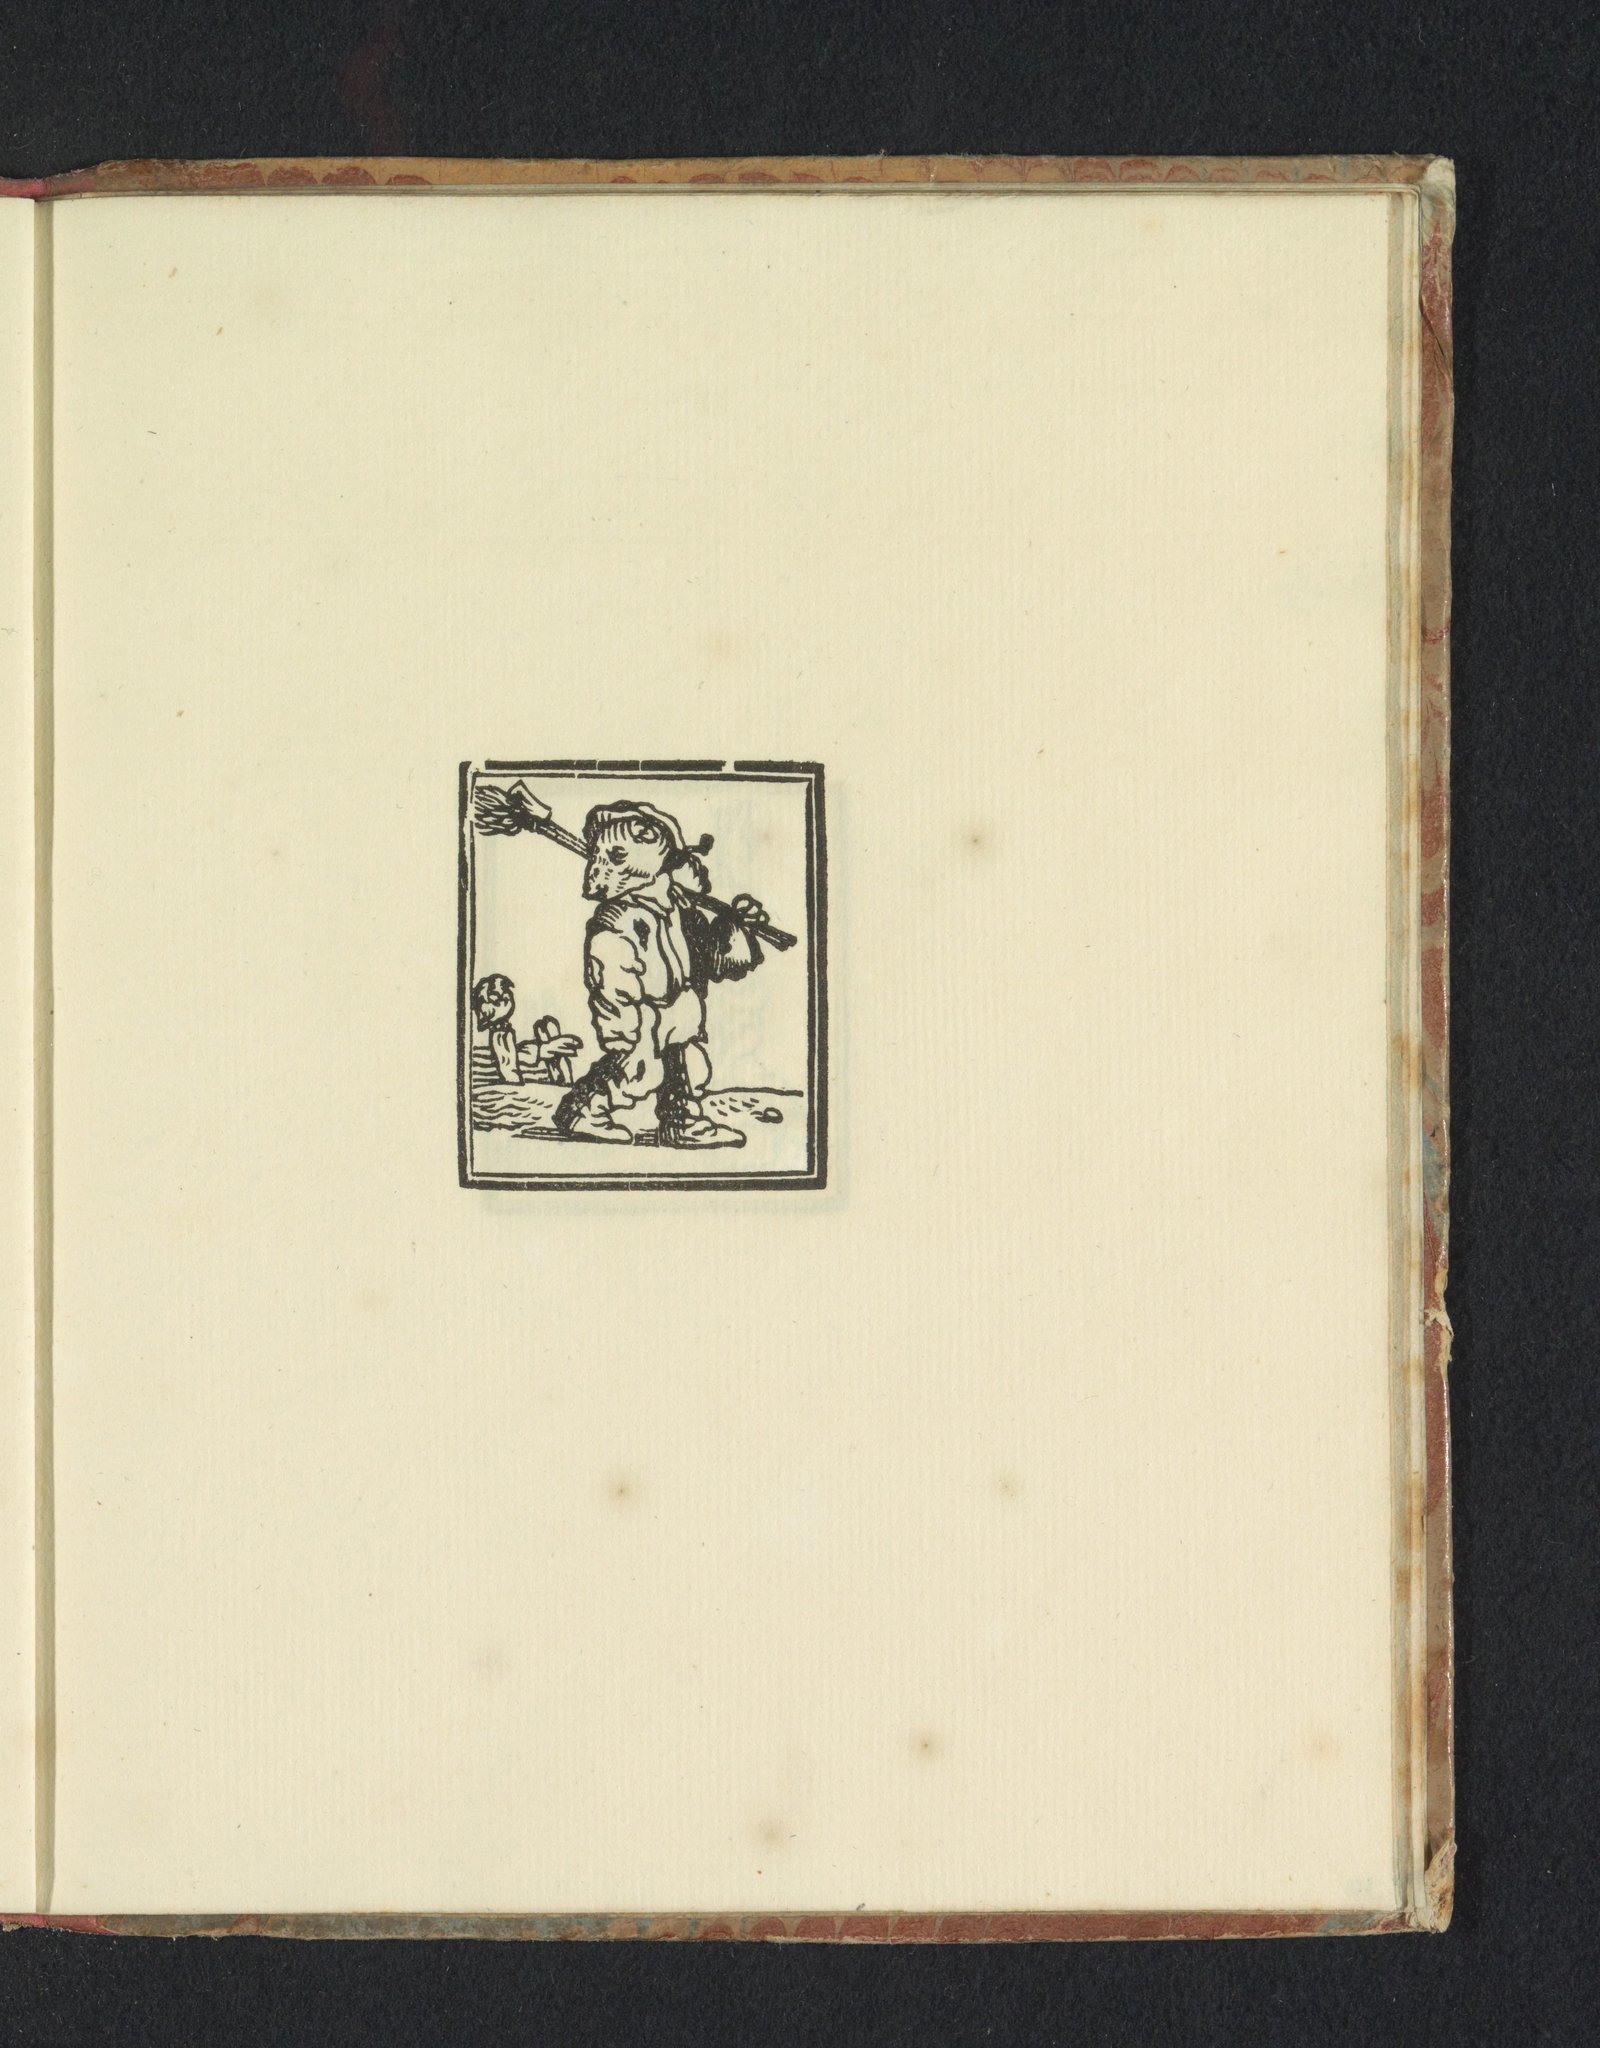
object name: popular print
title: As-beer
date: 1731-1732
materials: paper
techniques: woodcut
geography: haarlem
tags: caricatures (human types)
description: Koddige figuur, in het onderschrift in de overzichtsprent draagt deze figuur de naam: As-beer. Onderdeel van het boekje: XXXVI. aartige figuuren, geinventeert door Izaak van Ostade tot Haarlem [1731-1732].